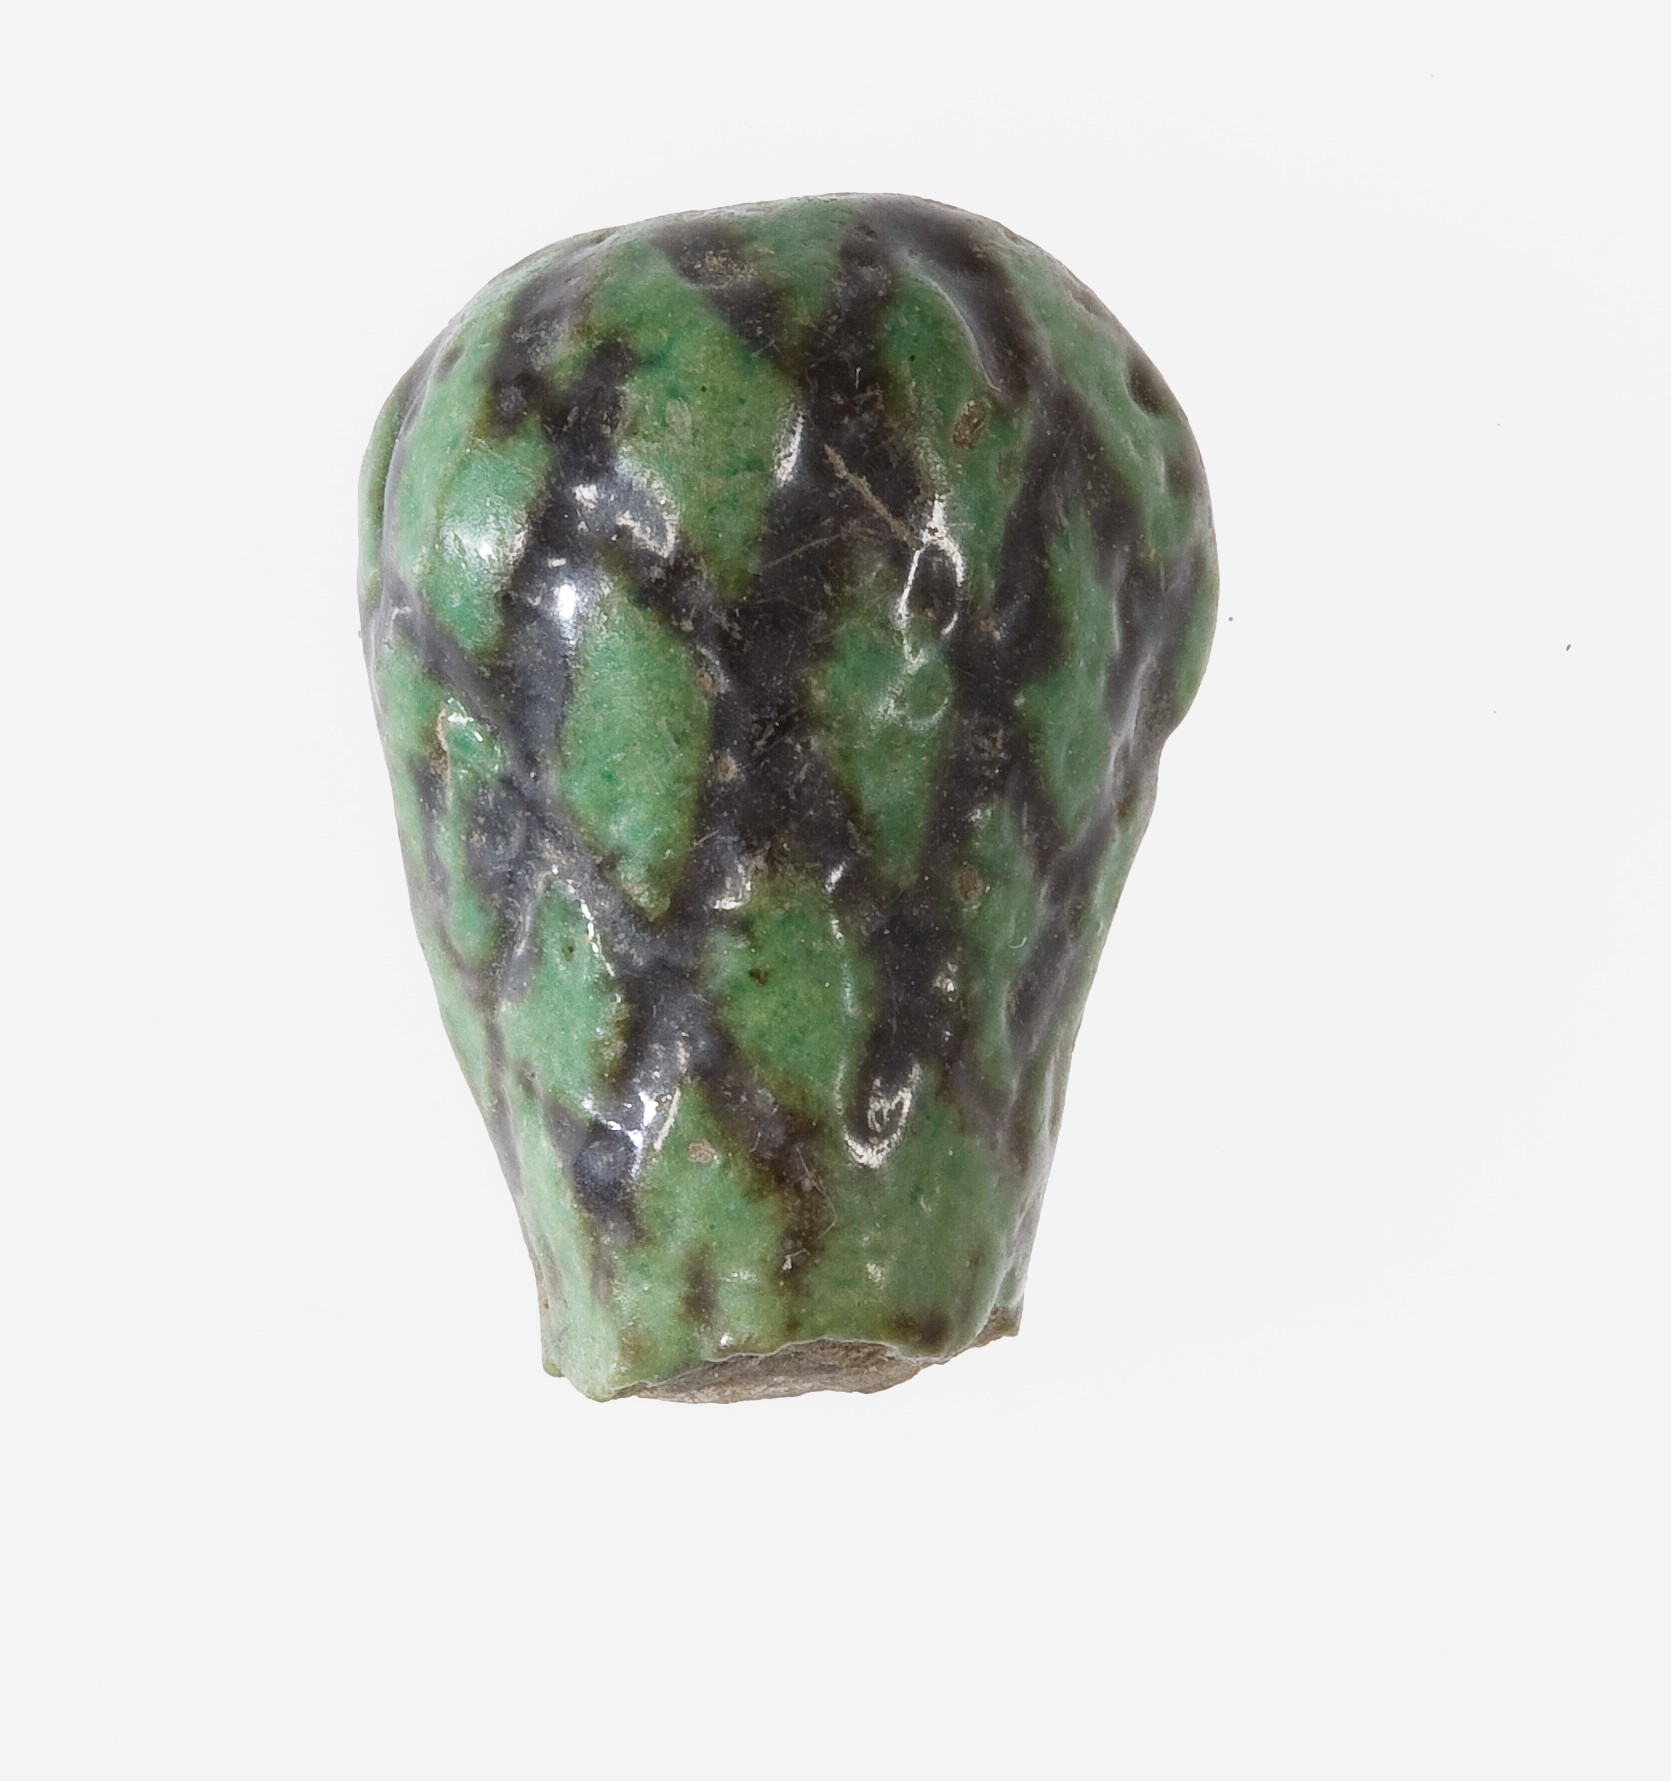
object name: pendant, cornflower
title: Cornflower Pendant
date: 1390-1352 BCE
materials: faience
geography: egypt